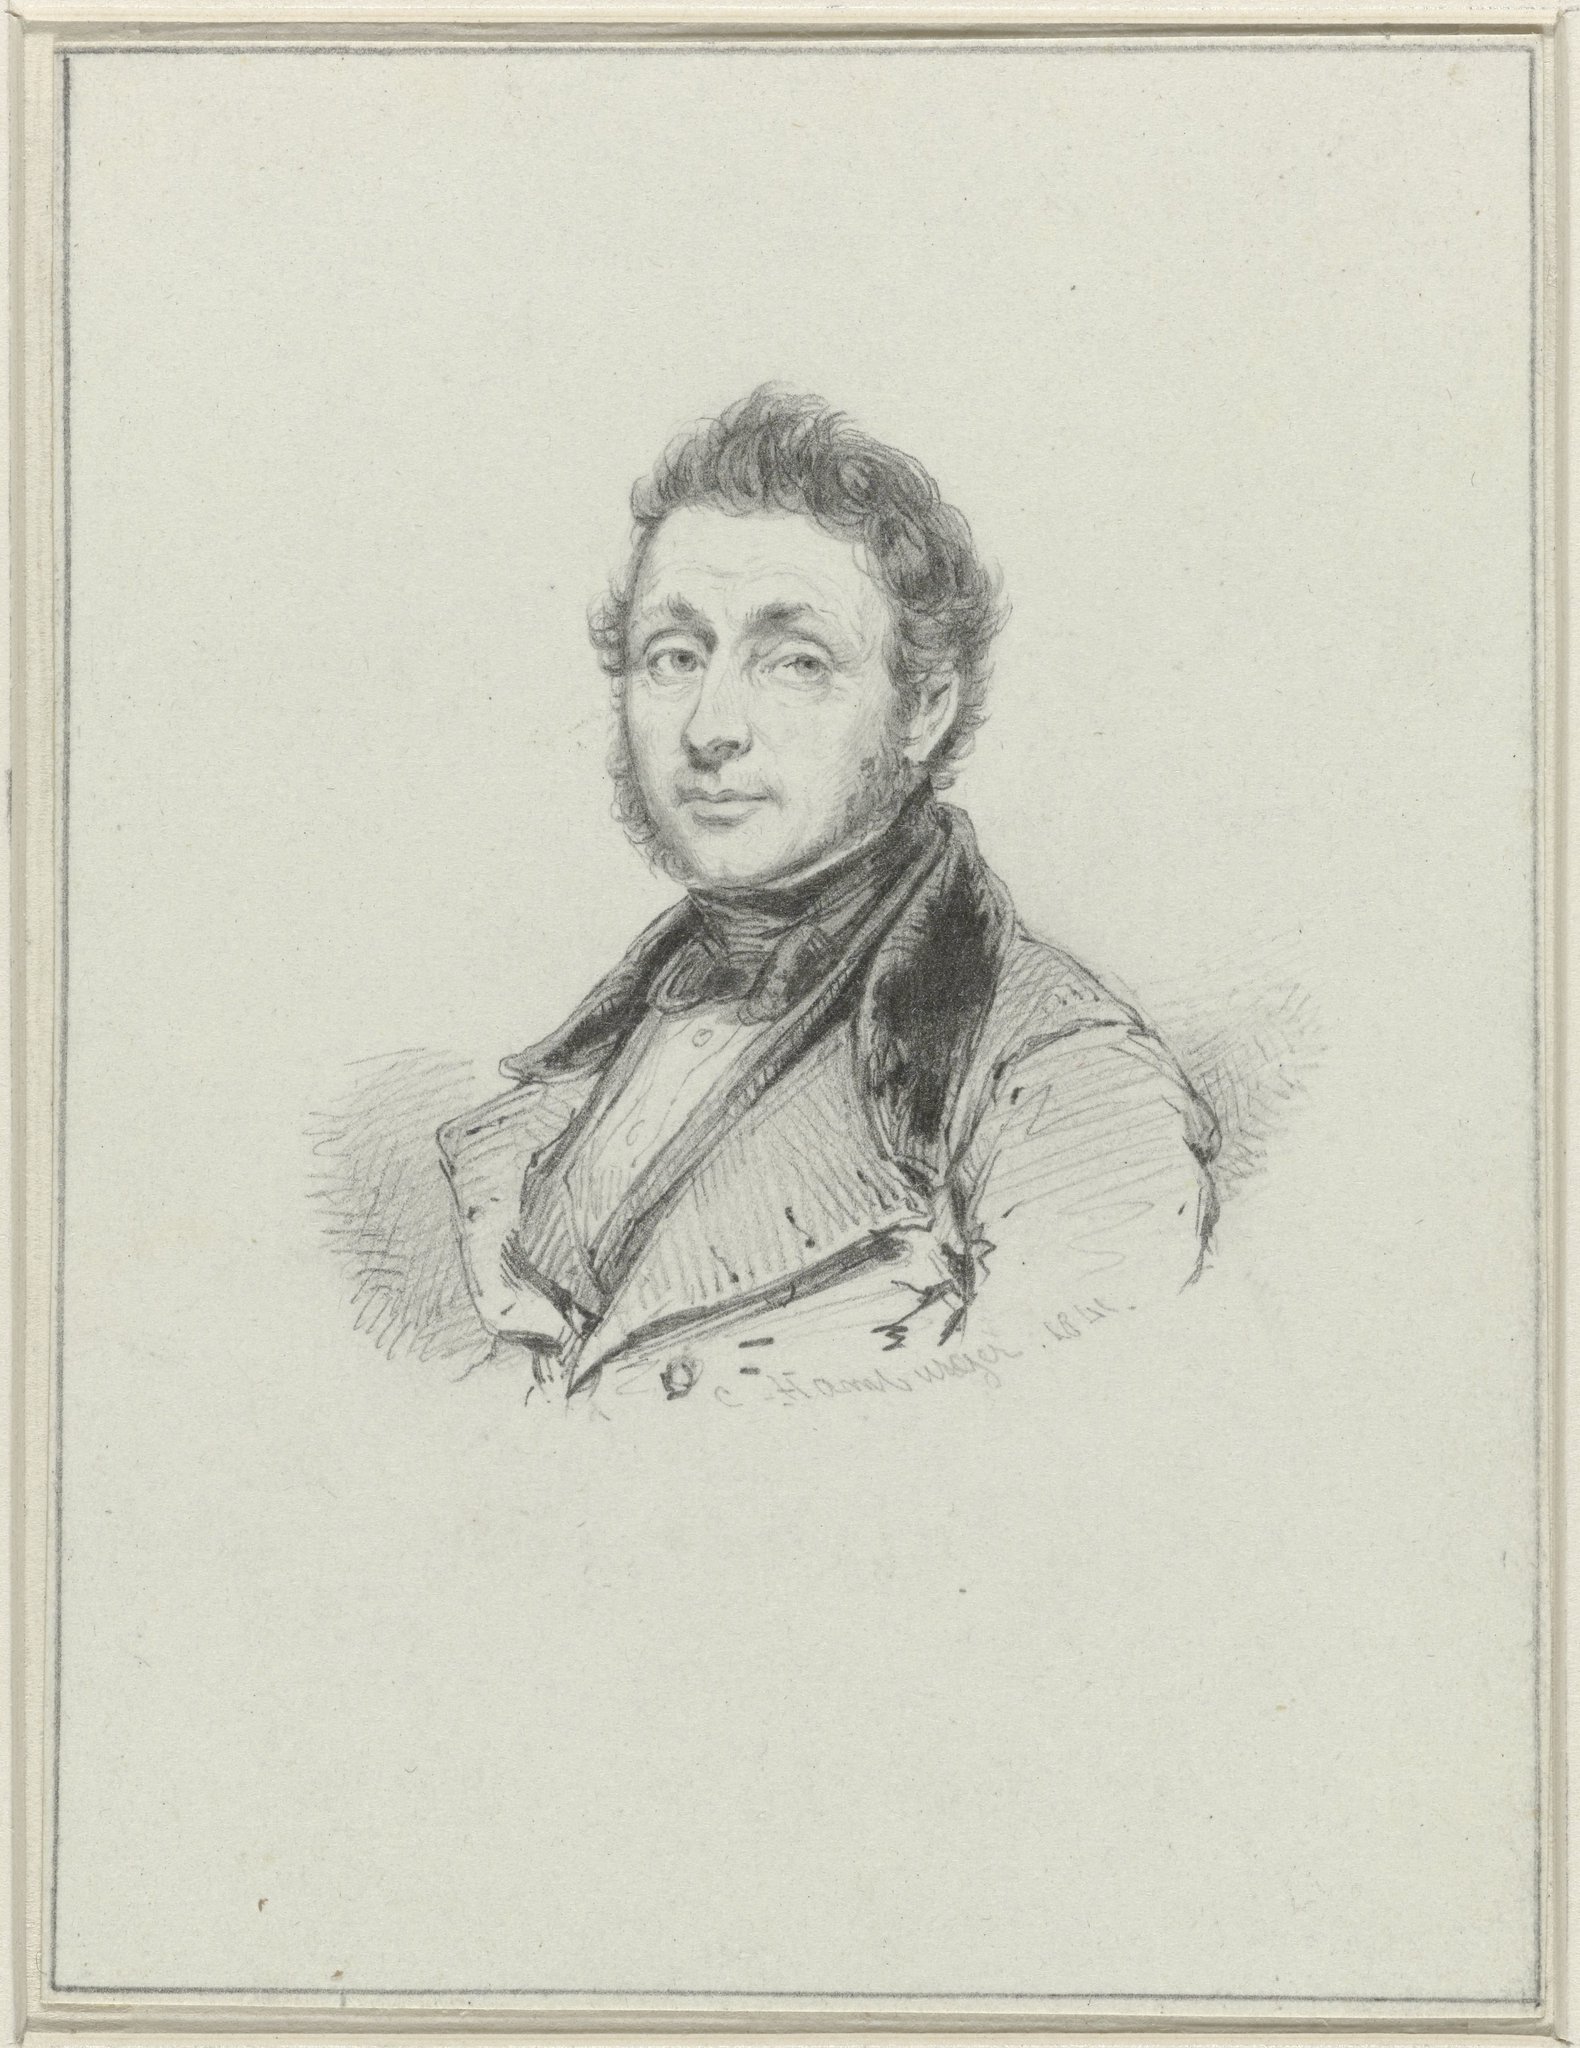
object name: drawing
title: Portret van Johan David Zocher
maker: coenraad hamburger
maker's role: draughtsman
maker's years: 1809-1891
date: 1841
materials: paper, pencil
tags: haarlem, designer, johan david zocher, historical persons, portrait, self-portrait of architect, french or architectonic garden; formal garden, portrait, self-portrait of artist, portrait, self-portrait of draughtsman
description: Portret van de tuinarchitect en tekenaar Johan David Zocher.